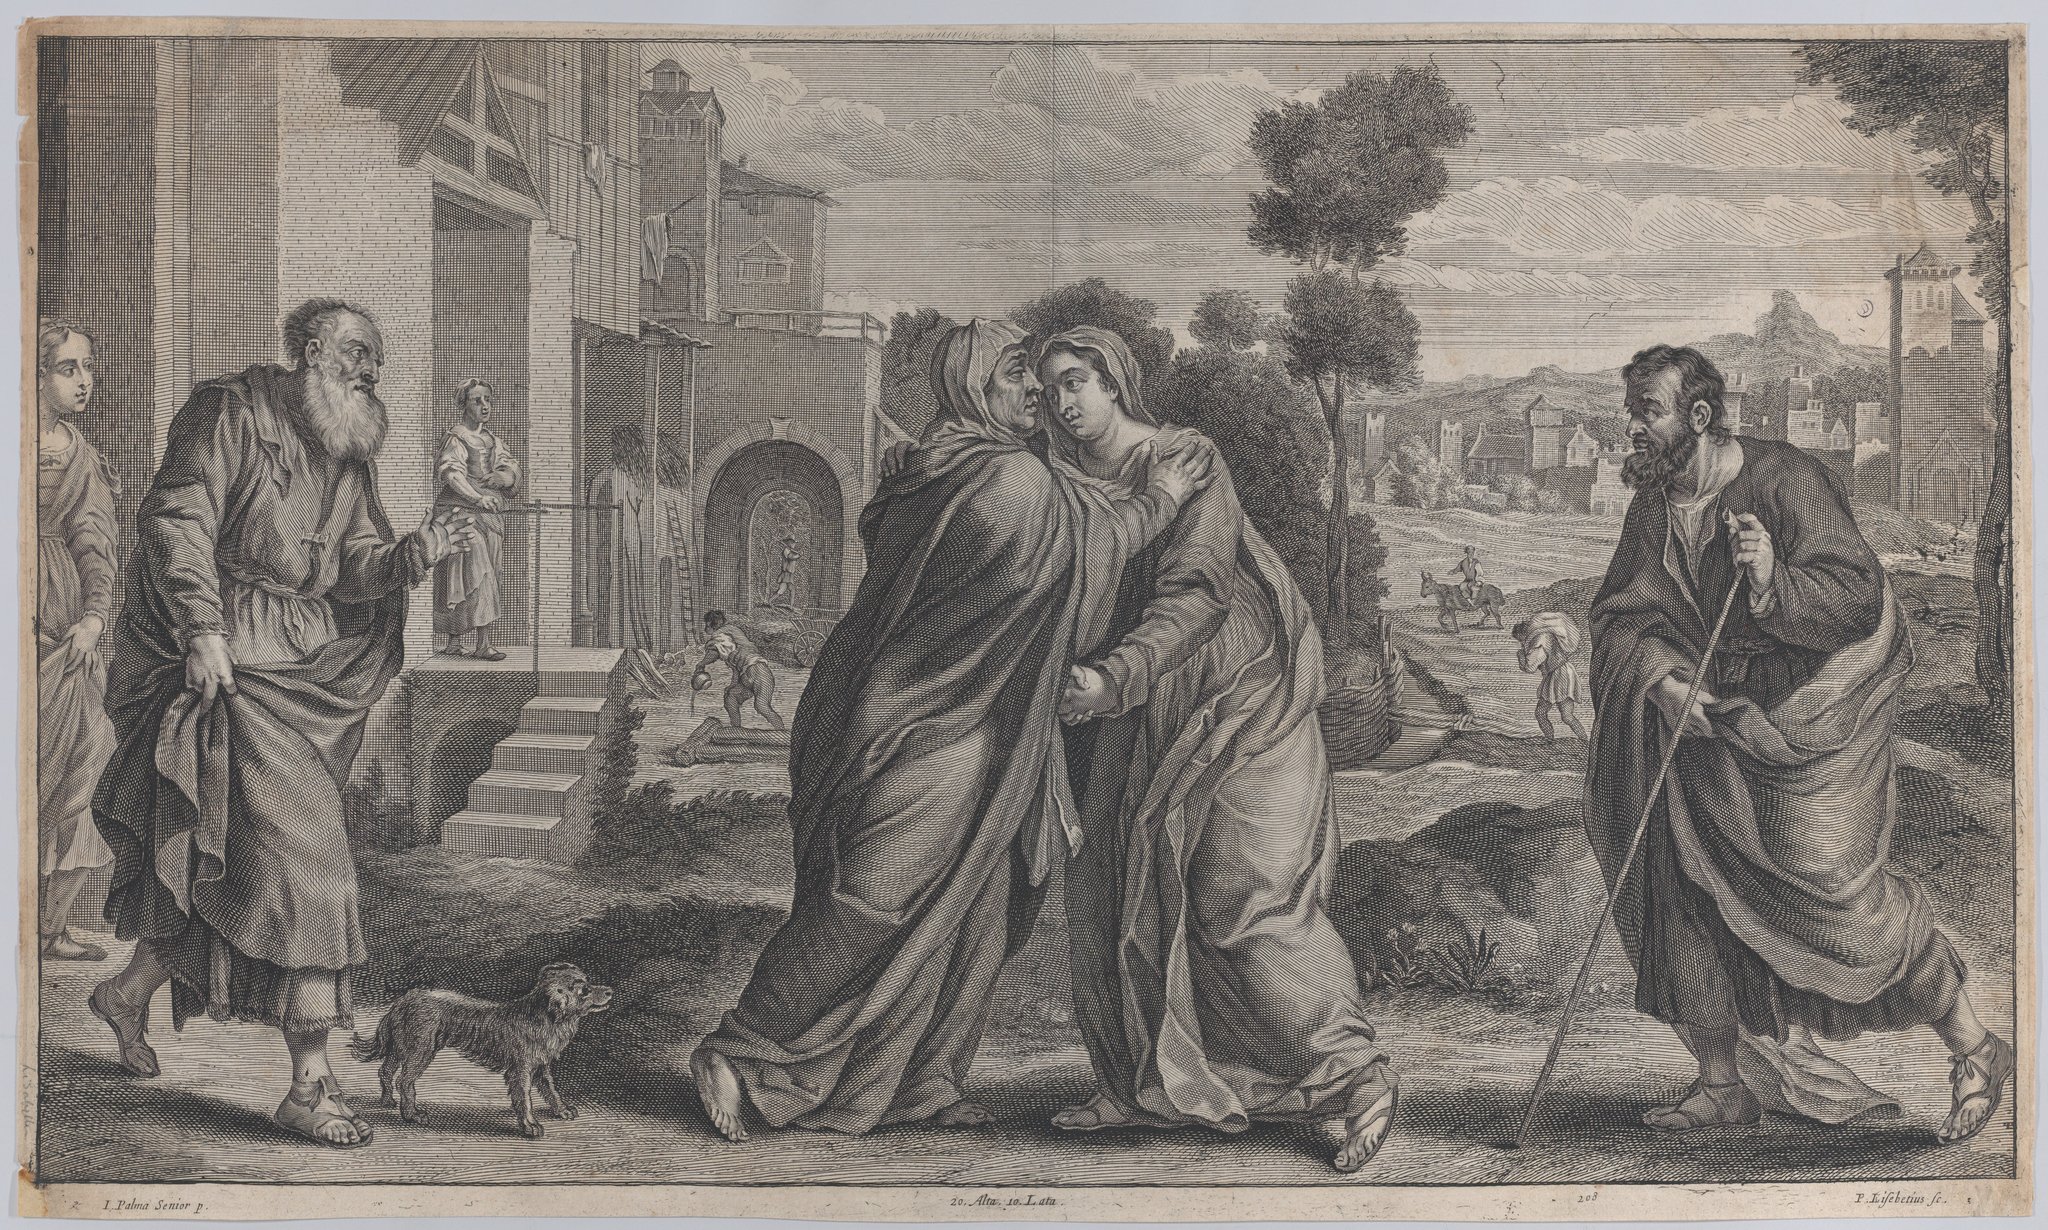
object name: print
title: Visitation; Saint Elizabeth embracing the Virgin at center as Saint Joseph walks toward them on the right and Zacharias greets them on the left; from 'Theatrum Pictorium', after Palma Il Vecchio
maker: peeter van lisebetten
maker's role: artist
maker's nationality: flemish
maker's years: 1610-1678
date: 1656-1660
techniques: engraving, etching